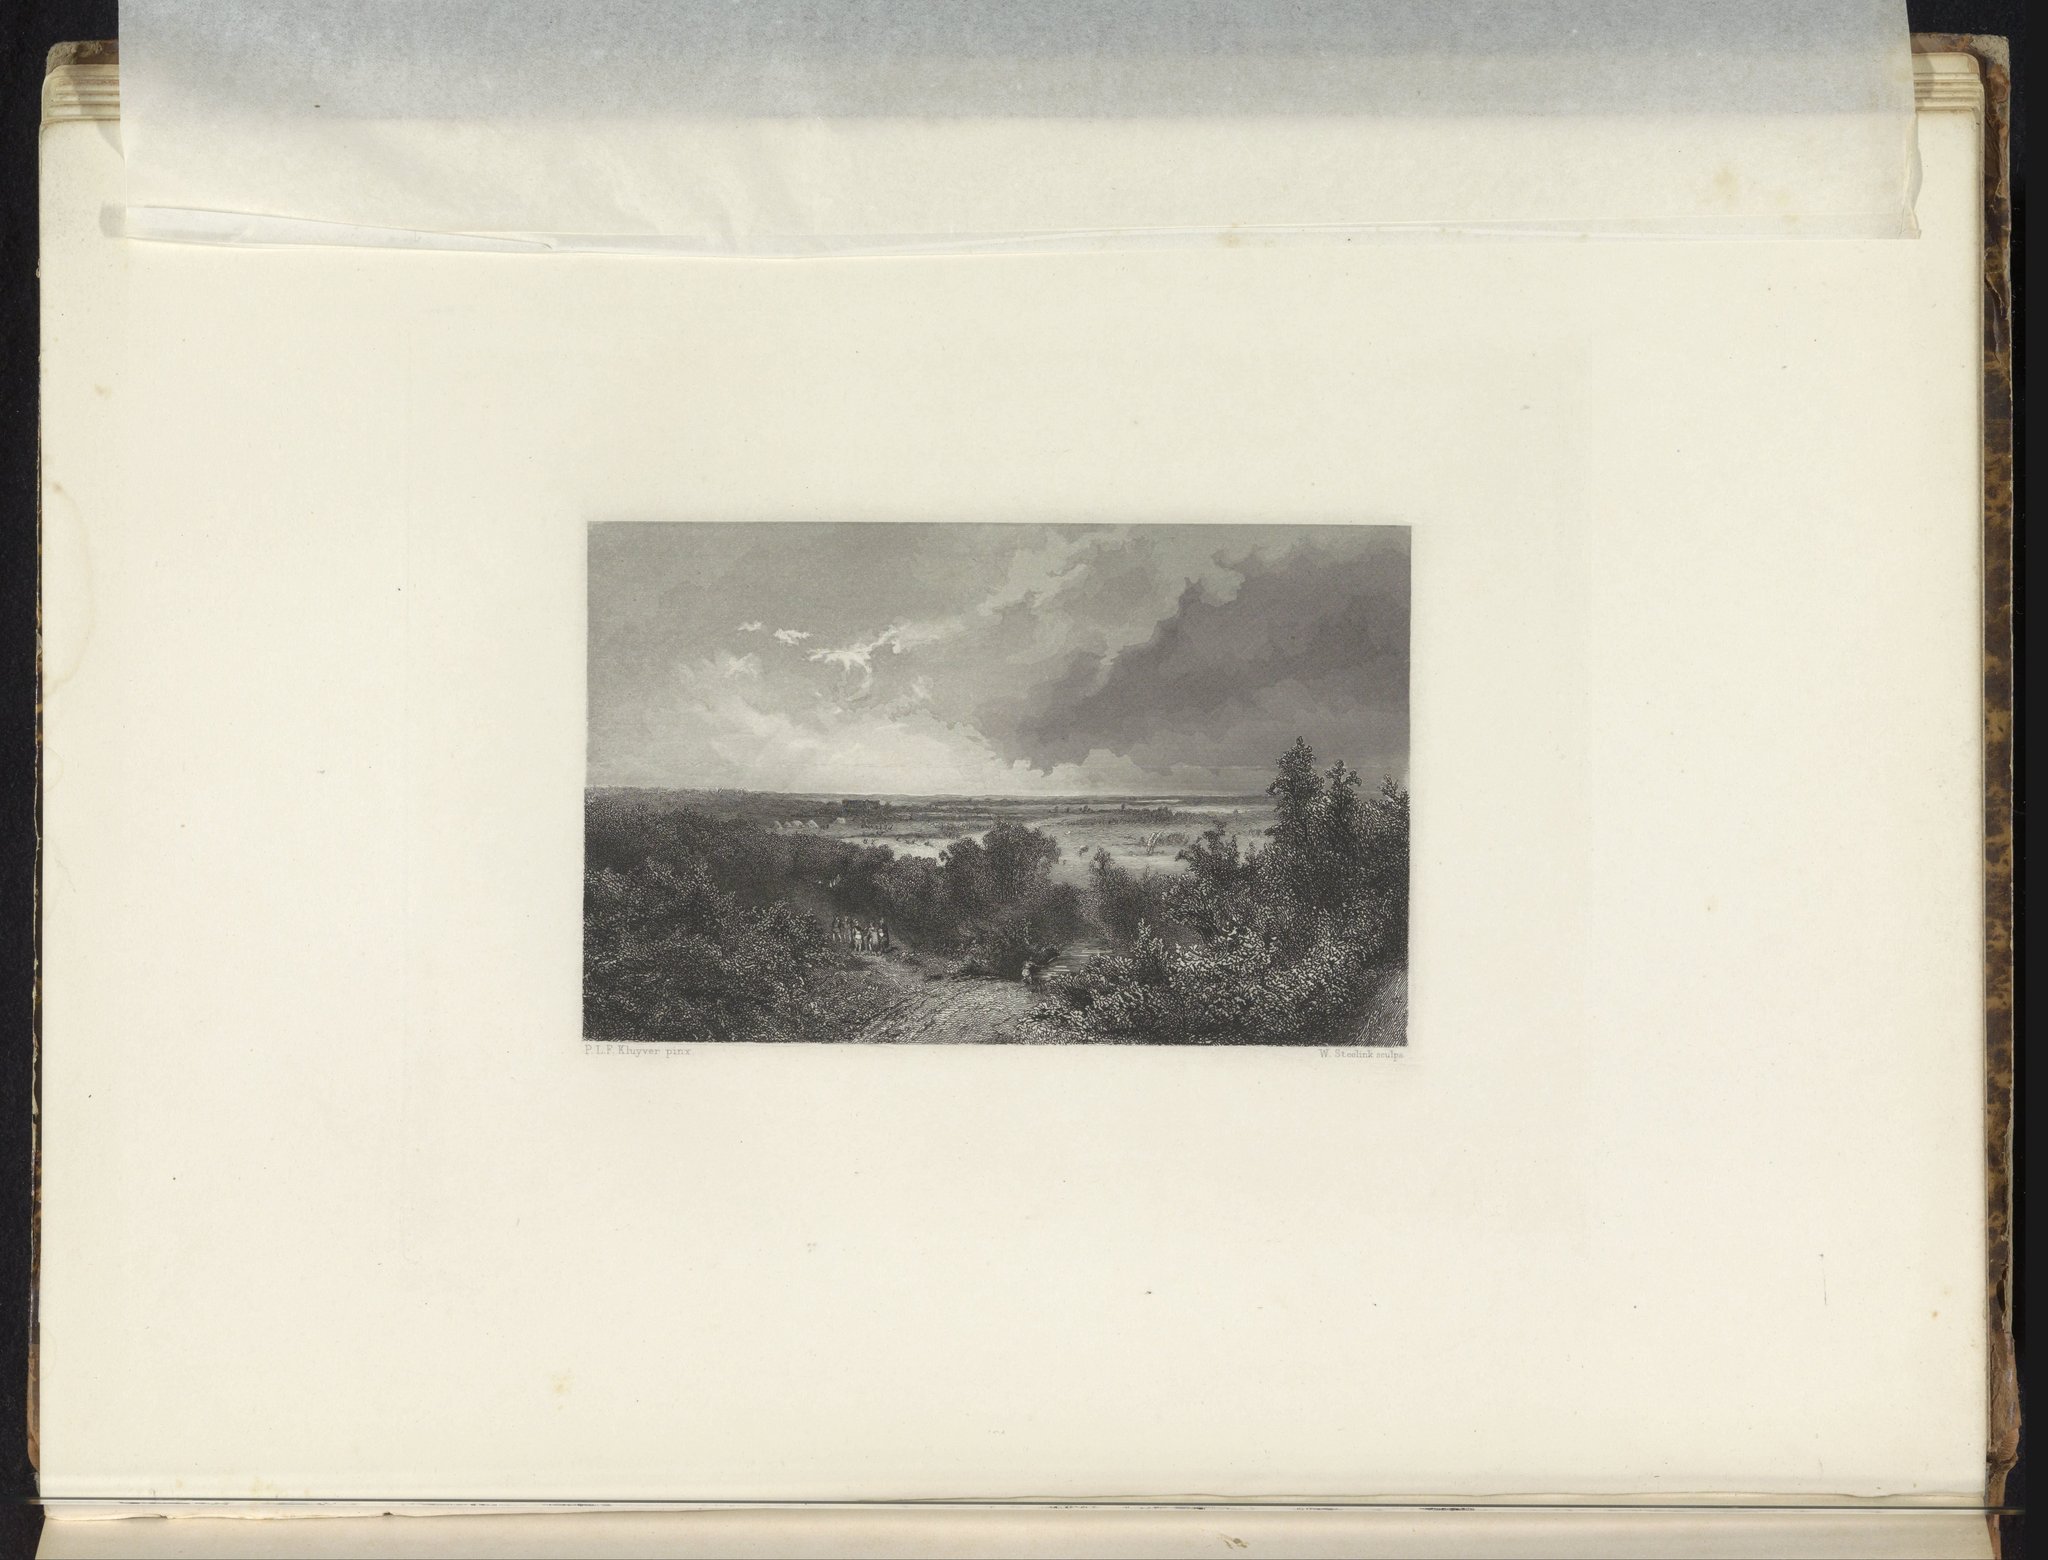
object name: history print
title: Het graven de Drususgracht door de Romeinen, ca. 15 v.C.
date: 1865-1870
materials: paper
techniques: engraving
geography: netherlands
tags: dikes, levee, netherlands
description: Uitgestrekt landschap waarin de Drususgracht in opdracht van de Romeinen wordt gegraven, ca. 15 v.C. Onderdeel van de groep staalgravures naar de schilderijen van de Historische Galerij der Maatschappij Arti et Amicitiae.